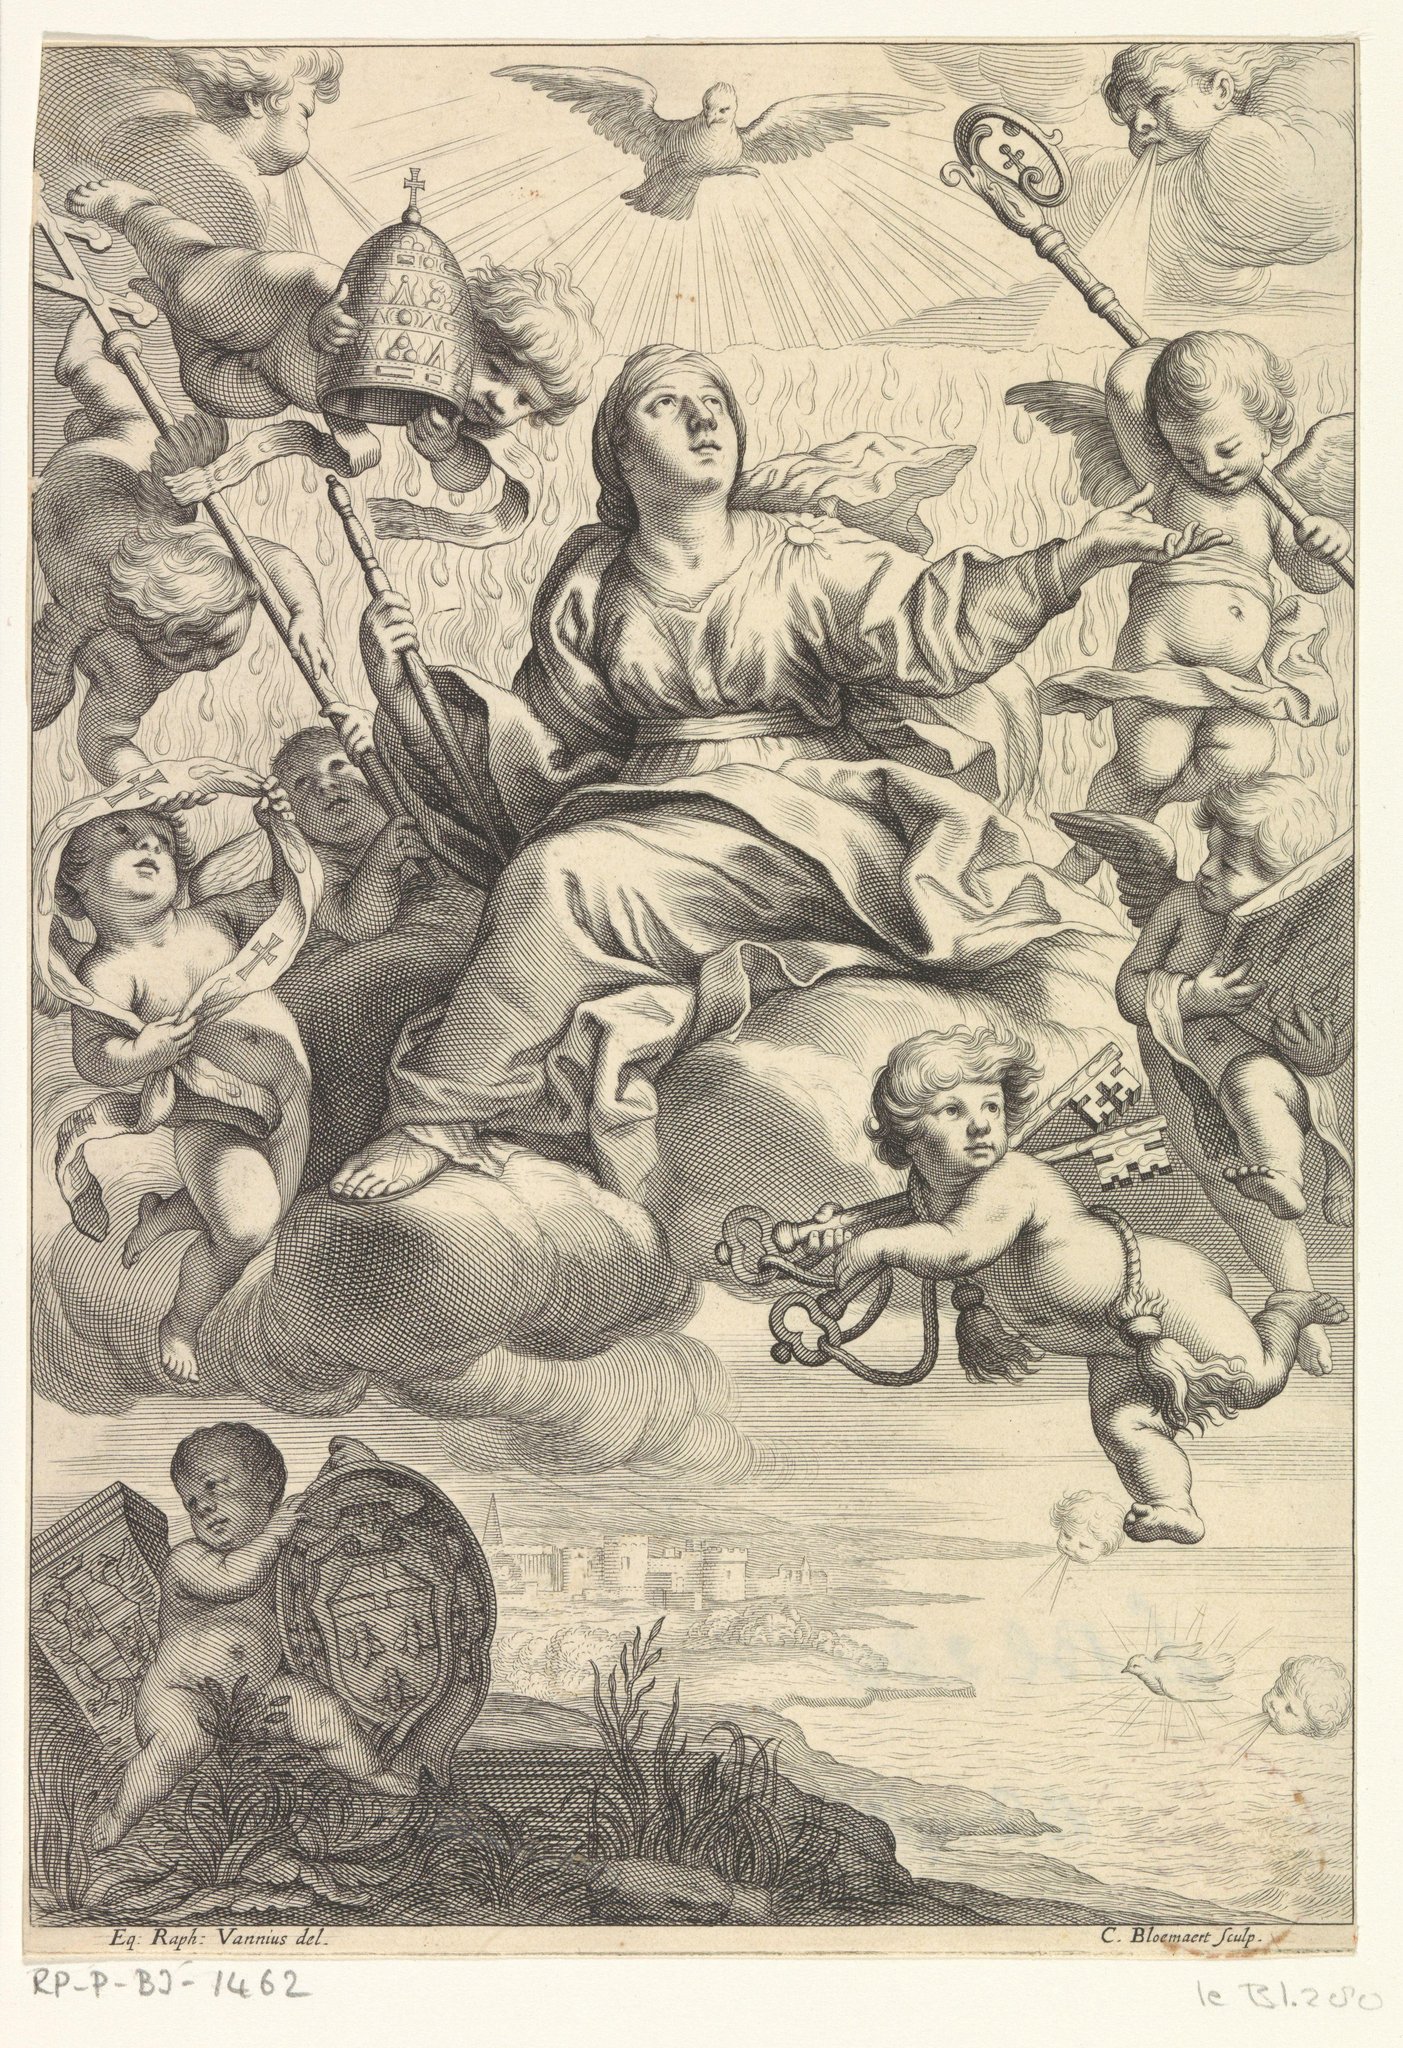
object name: print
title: Allegorie met de heilige Geest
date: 1633-1692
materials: paper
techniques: engraving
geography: rome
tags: the holy ghost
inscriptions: collector's mark: Lugt 240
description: Een vrouw zit op een wolk, omgeven door engelen. De engelen houden een bisschopstaf, een mijter, een paar sleutels, een boek en een banier vast. De vrouw representeert de Kerk. Boven de vrouw zweeft een duif, de heilige Geest. Onder een putto met een kardinaalswapen.